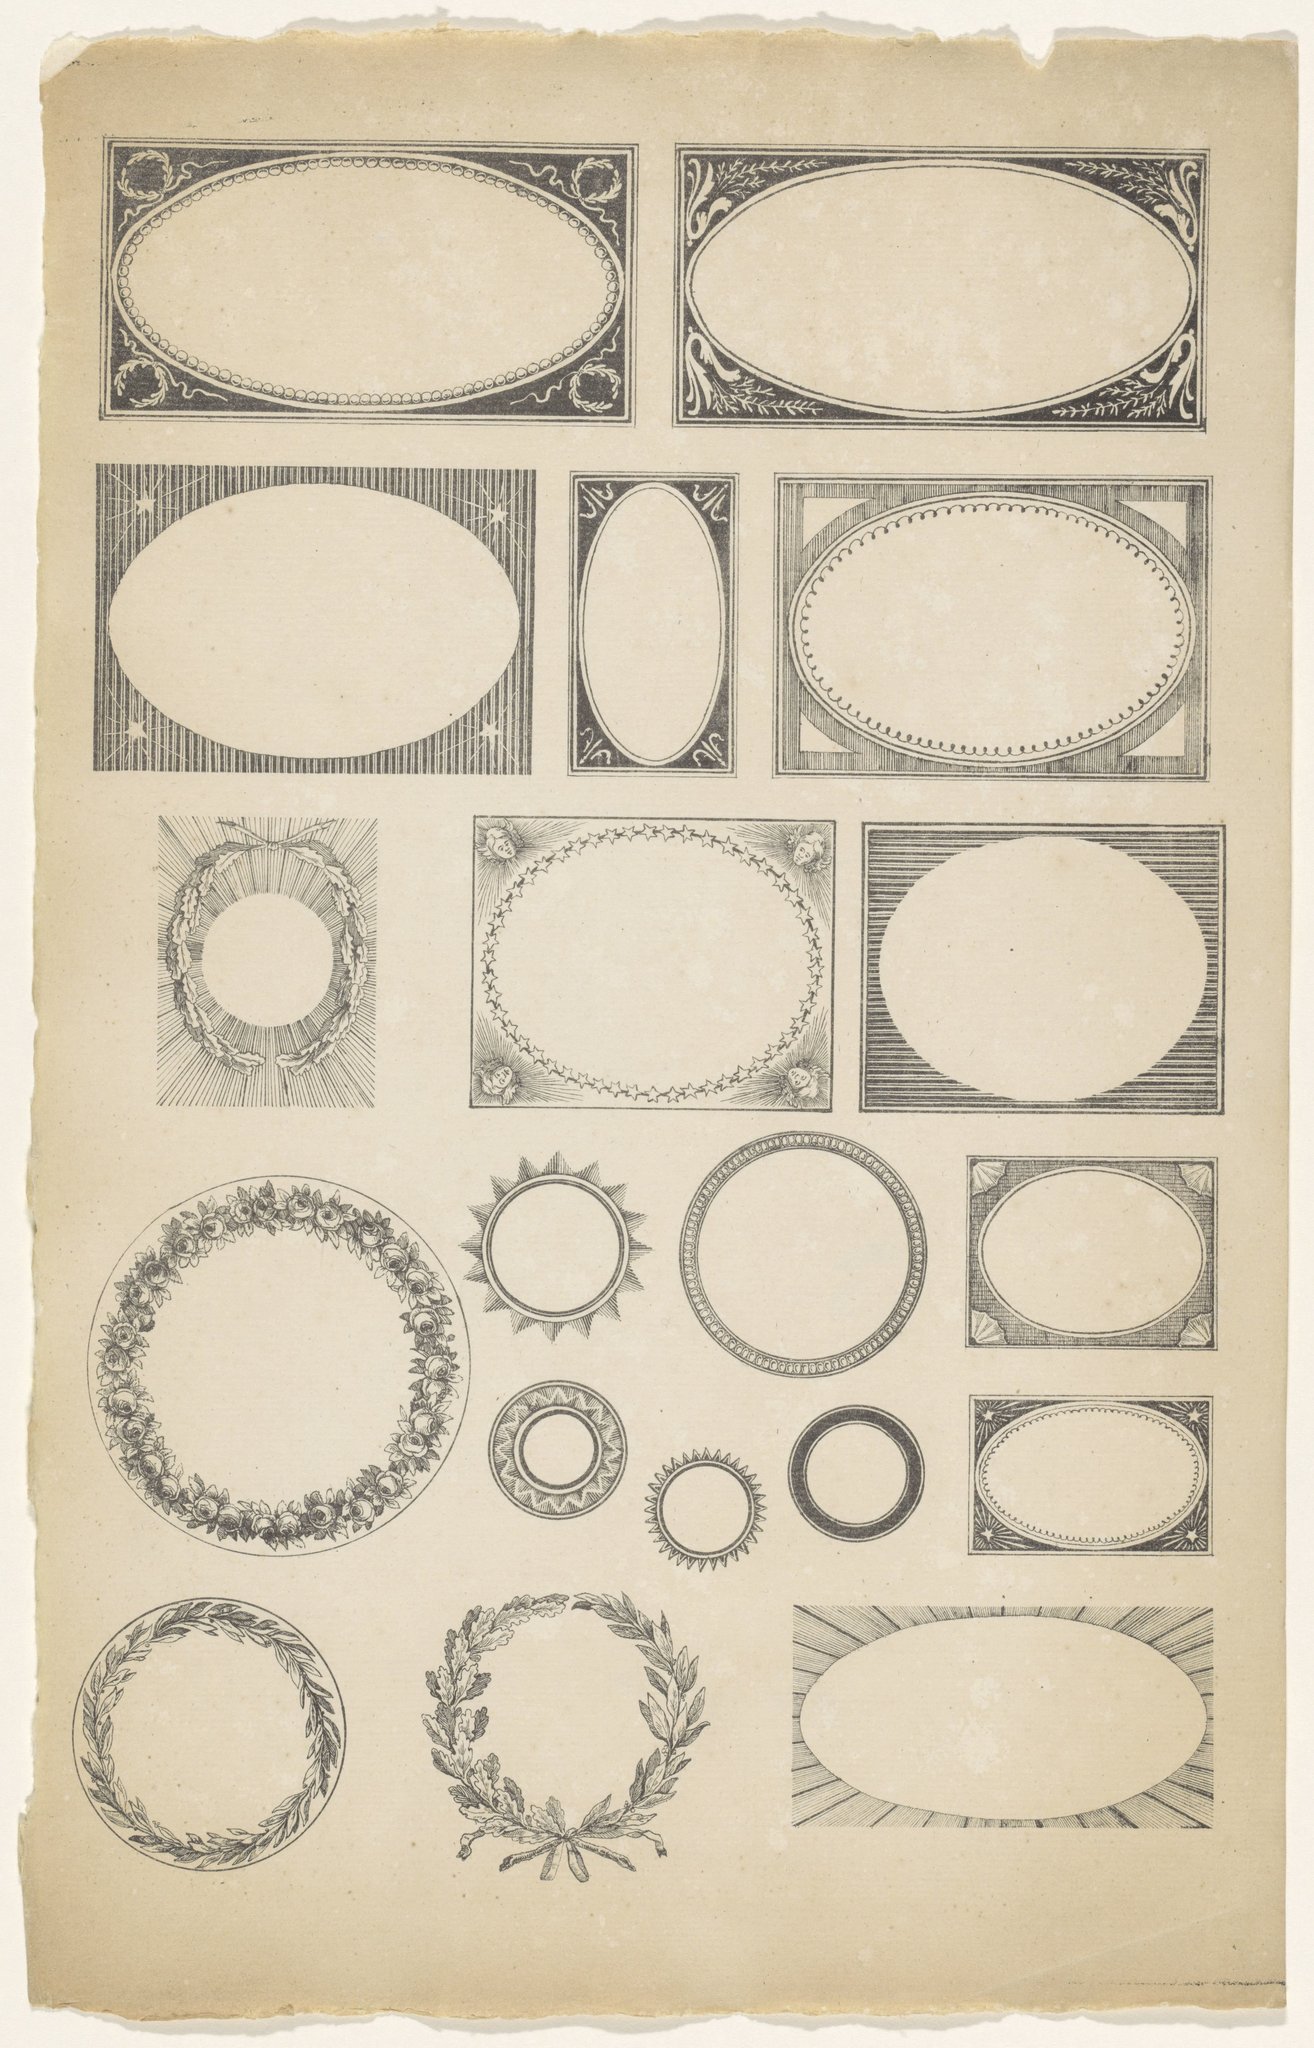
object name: ornament print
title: Verschillende ontwerpen voor etiketten en medaillons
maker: Anonymous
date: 1750-1800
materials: paper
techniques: engraving, etching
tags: ornaments ~ art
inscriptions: collector's mark: Lugt 2228